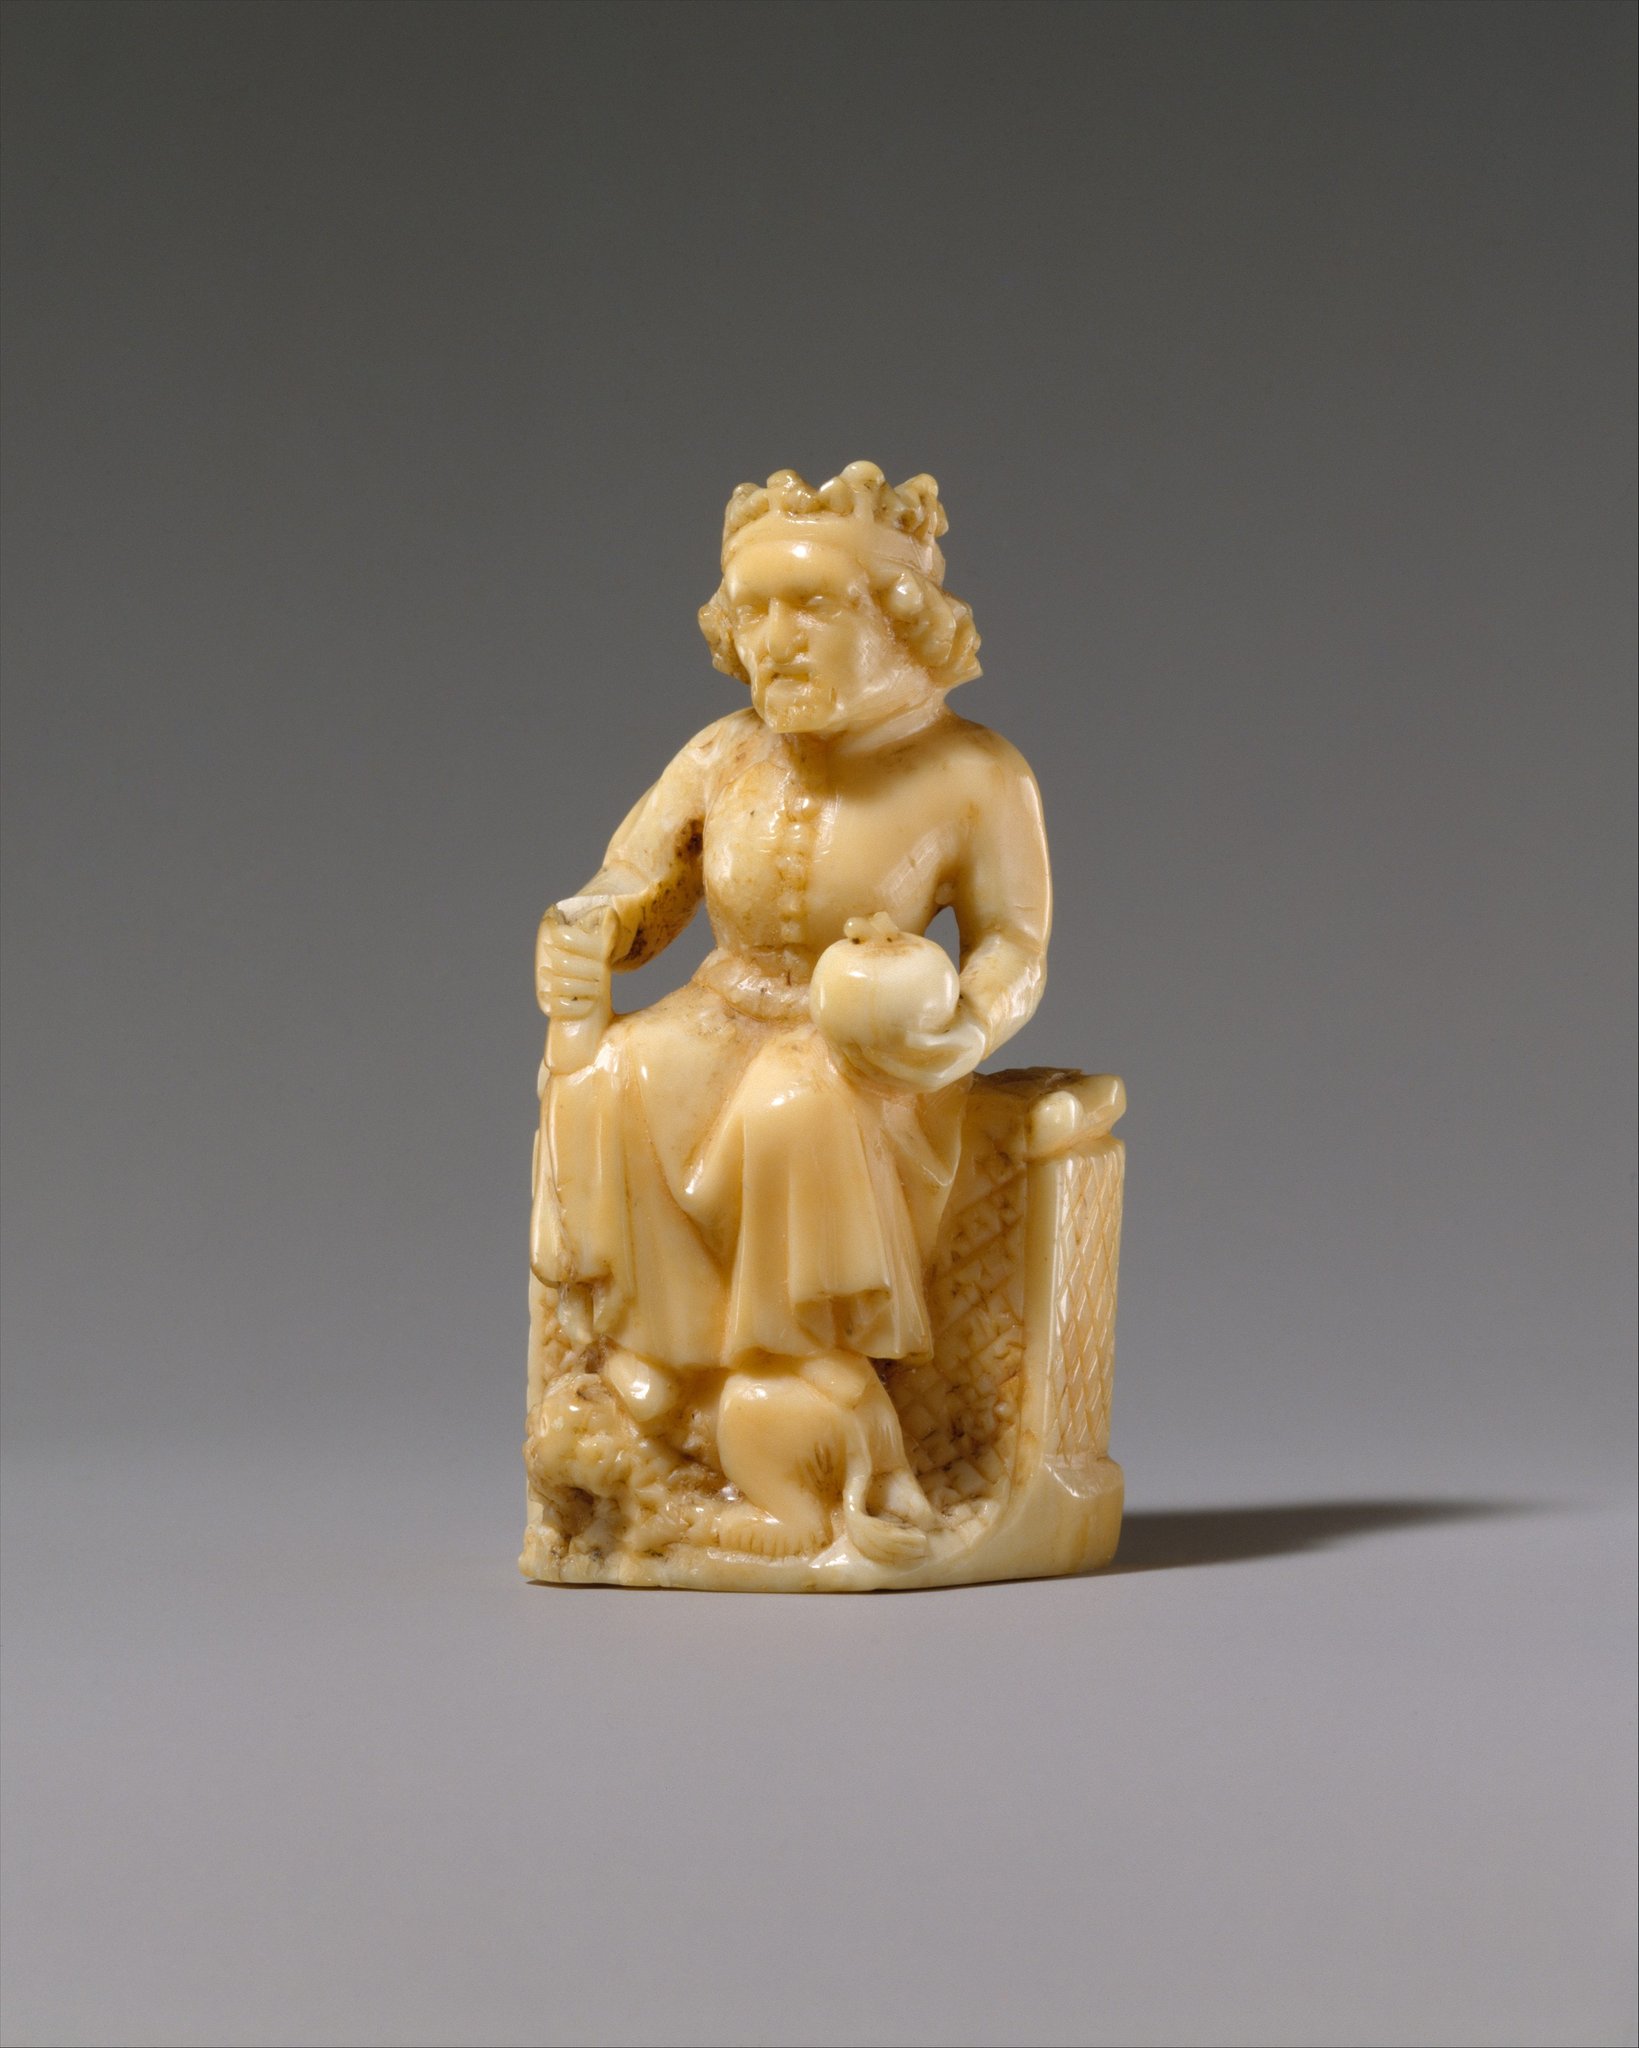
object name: chess piece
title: Chess Piece in the Form of a King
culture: german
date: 1350-1400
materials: ivory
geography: germany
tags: kings,chess